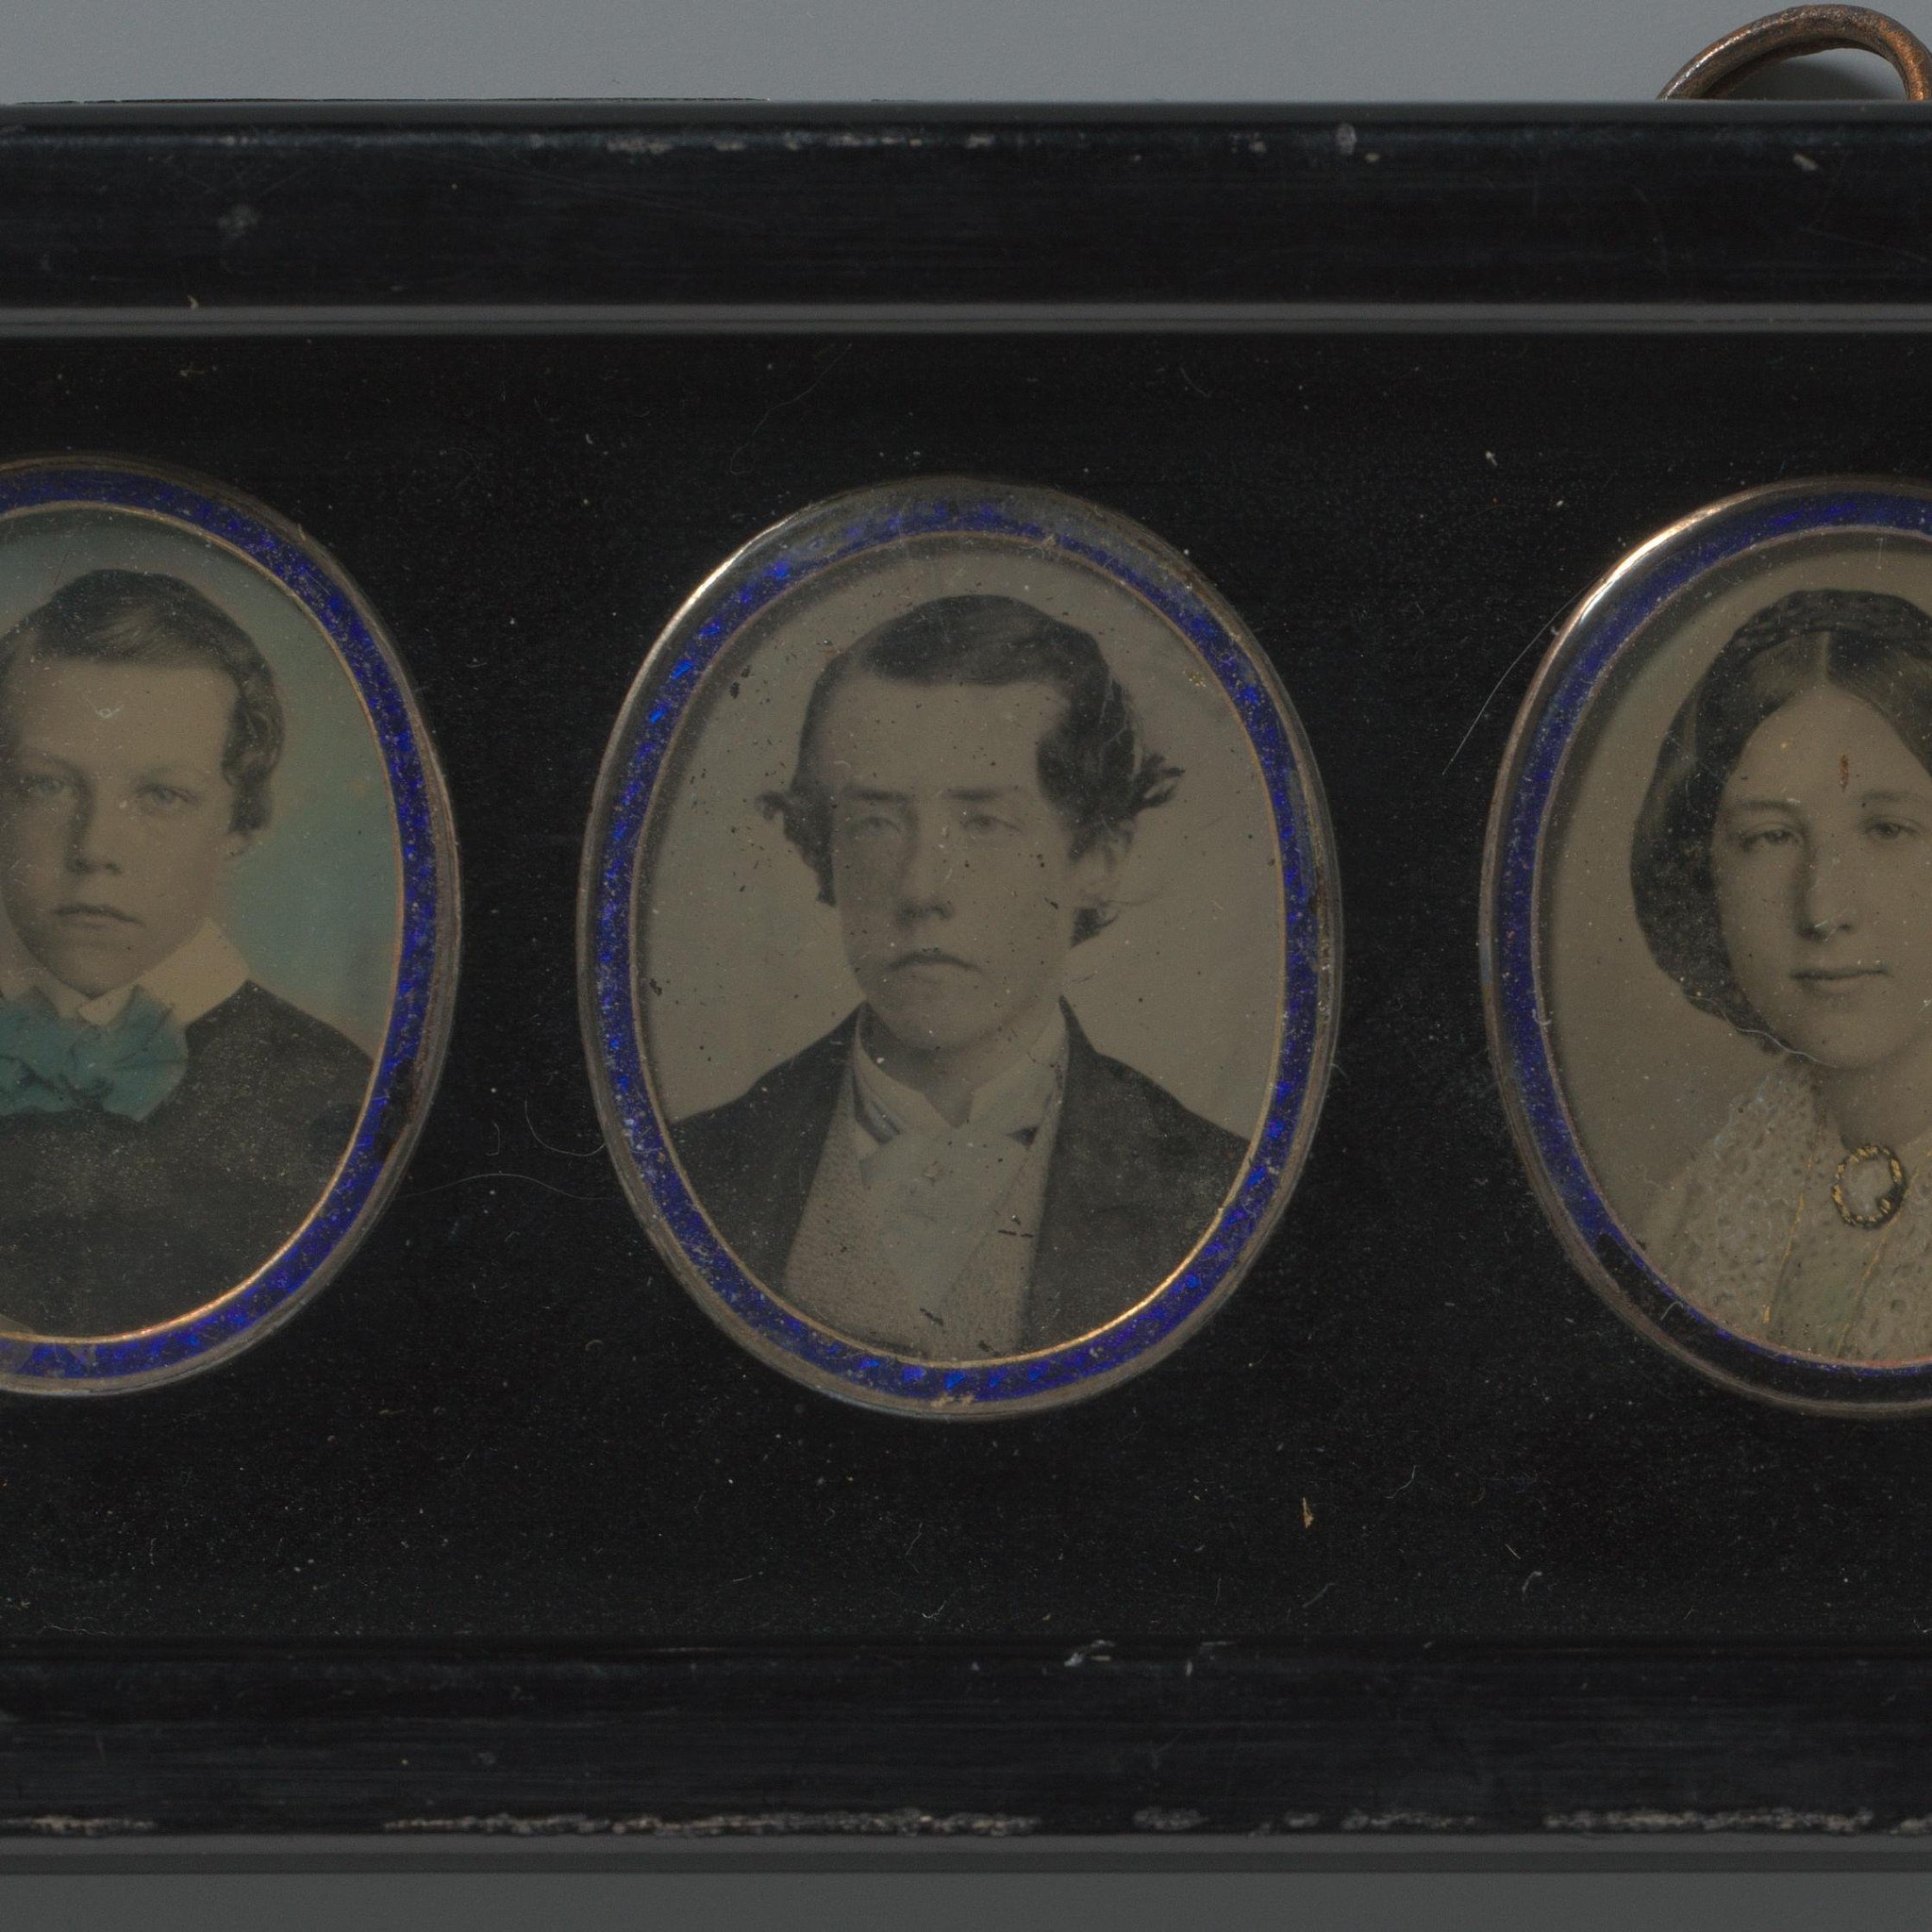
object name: frame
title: Portret van een onbekende jongeman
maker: Anonymous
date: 1855-1870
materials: glass, metal, paper, wood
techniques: ambrotype, hand coloring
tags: boy (child between toddler and youth), historical persons